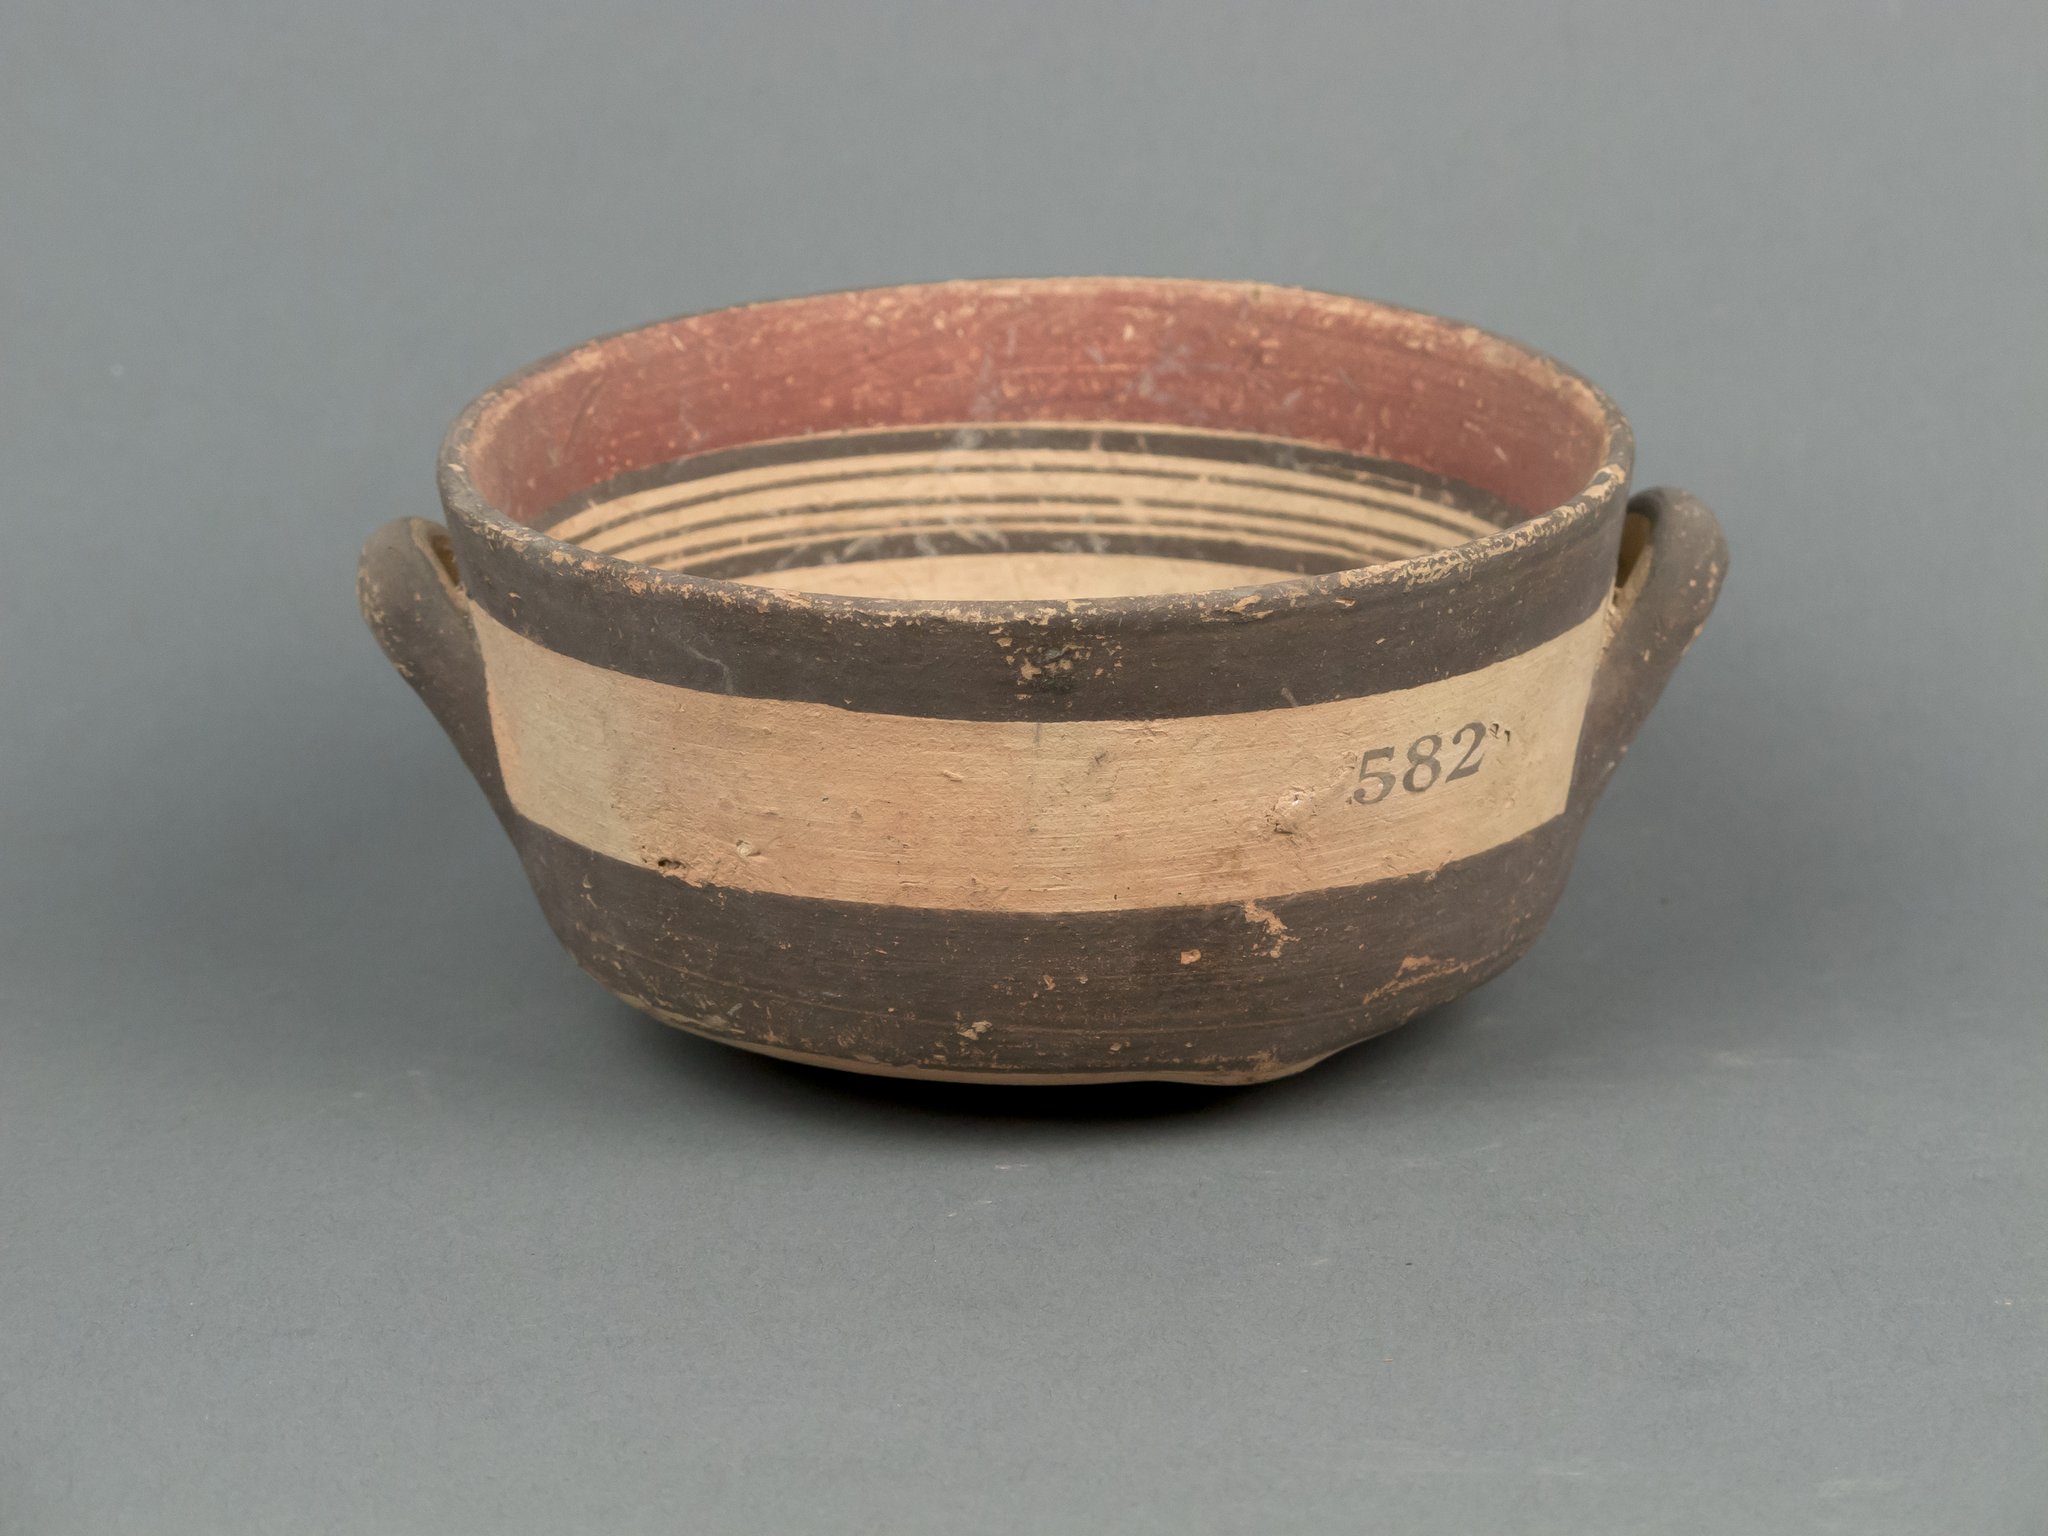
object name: bowl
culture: cypriot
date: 850-750 BCE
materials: terracotta